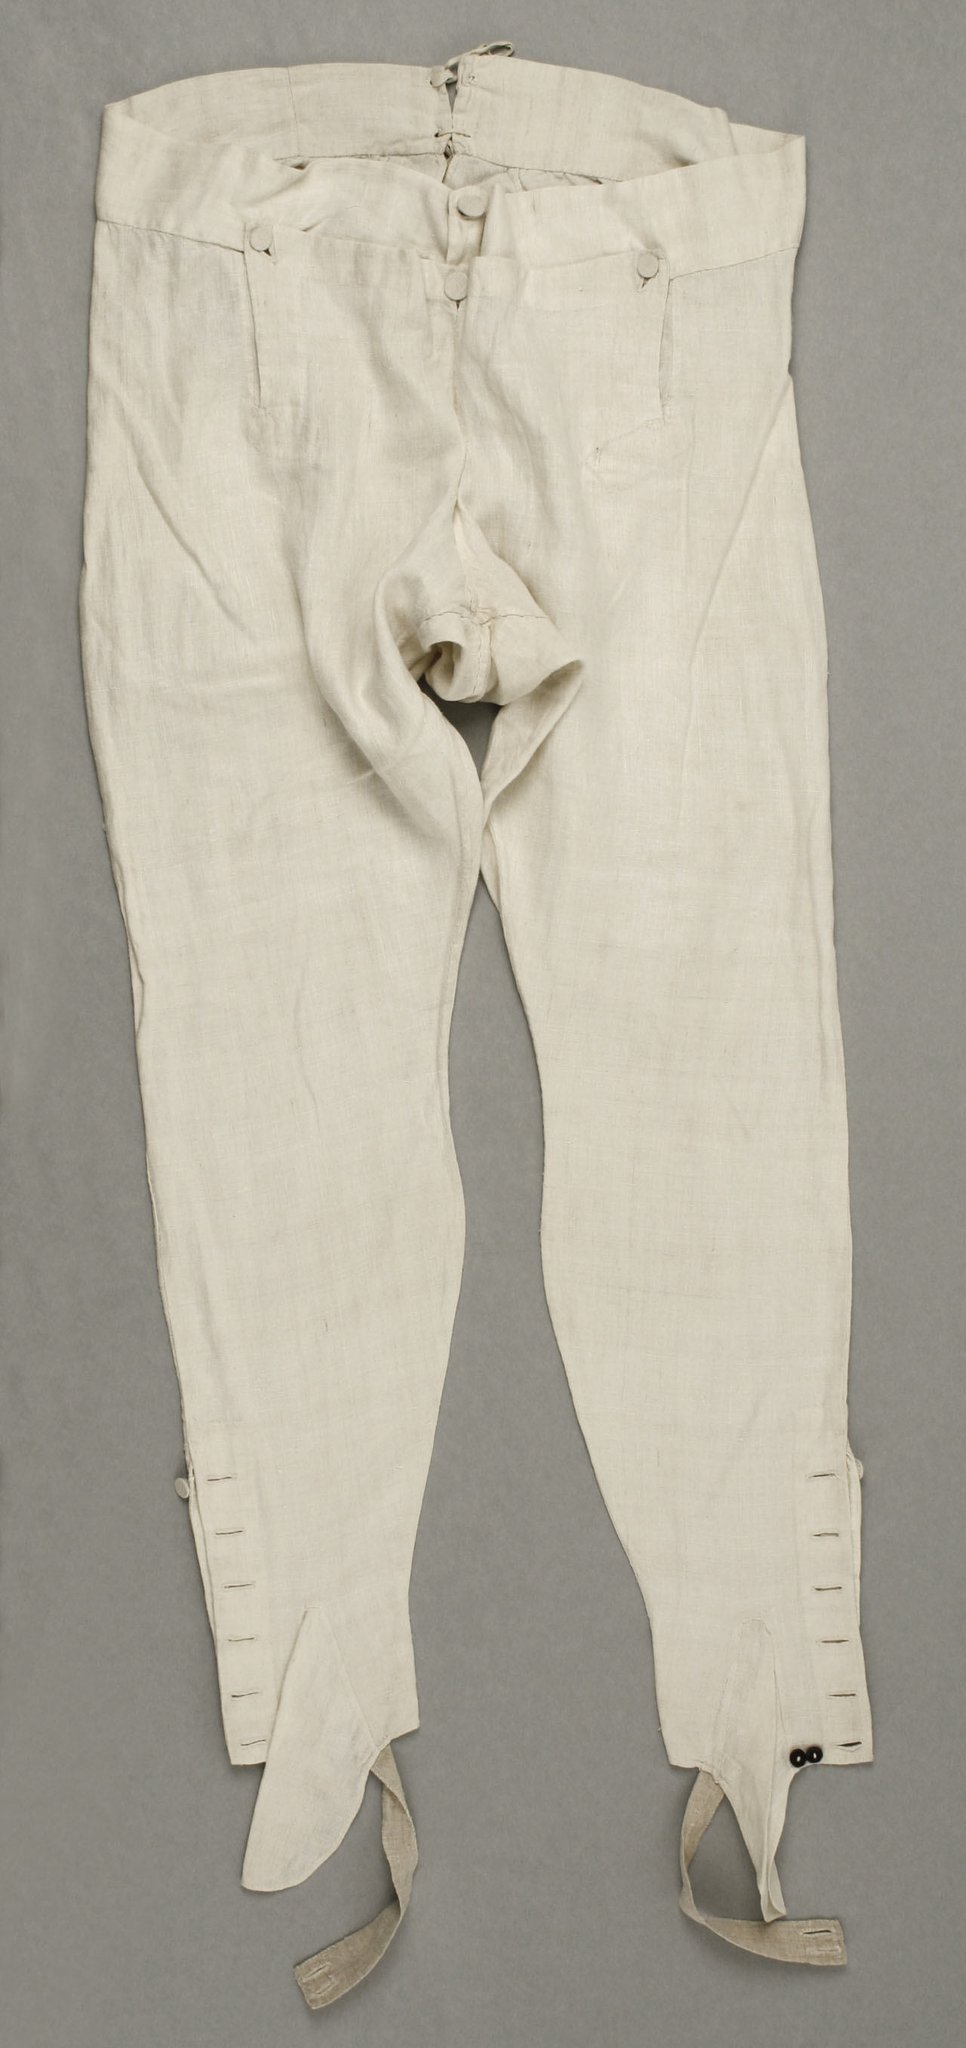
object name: pantaloon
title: Pantaloons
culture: american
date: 1830-1840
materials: linen